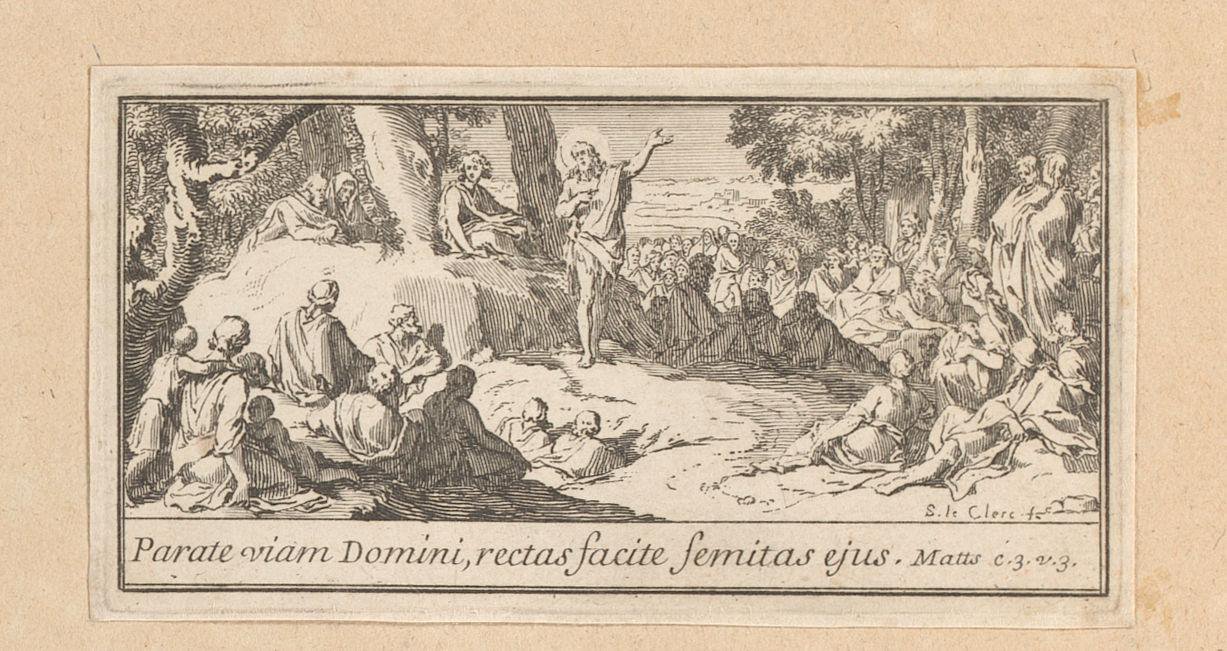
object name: book illustration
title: Prediking van Johannes de Doper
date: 1683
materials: paper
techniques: etching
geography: paris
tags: john the baptist preaching (perhaps christ among the bystanders)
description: Vignet uit: Rancé, Le P. Armand-Jean Baptiste Le Bouthillier de. De la sainteté et des devoirs de la vie monastique. Parijs: François Muguet, 1683.